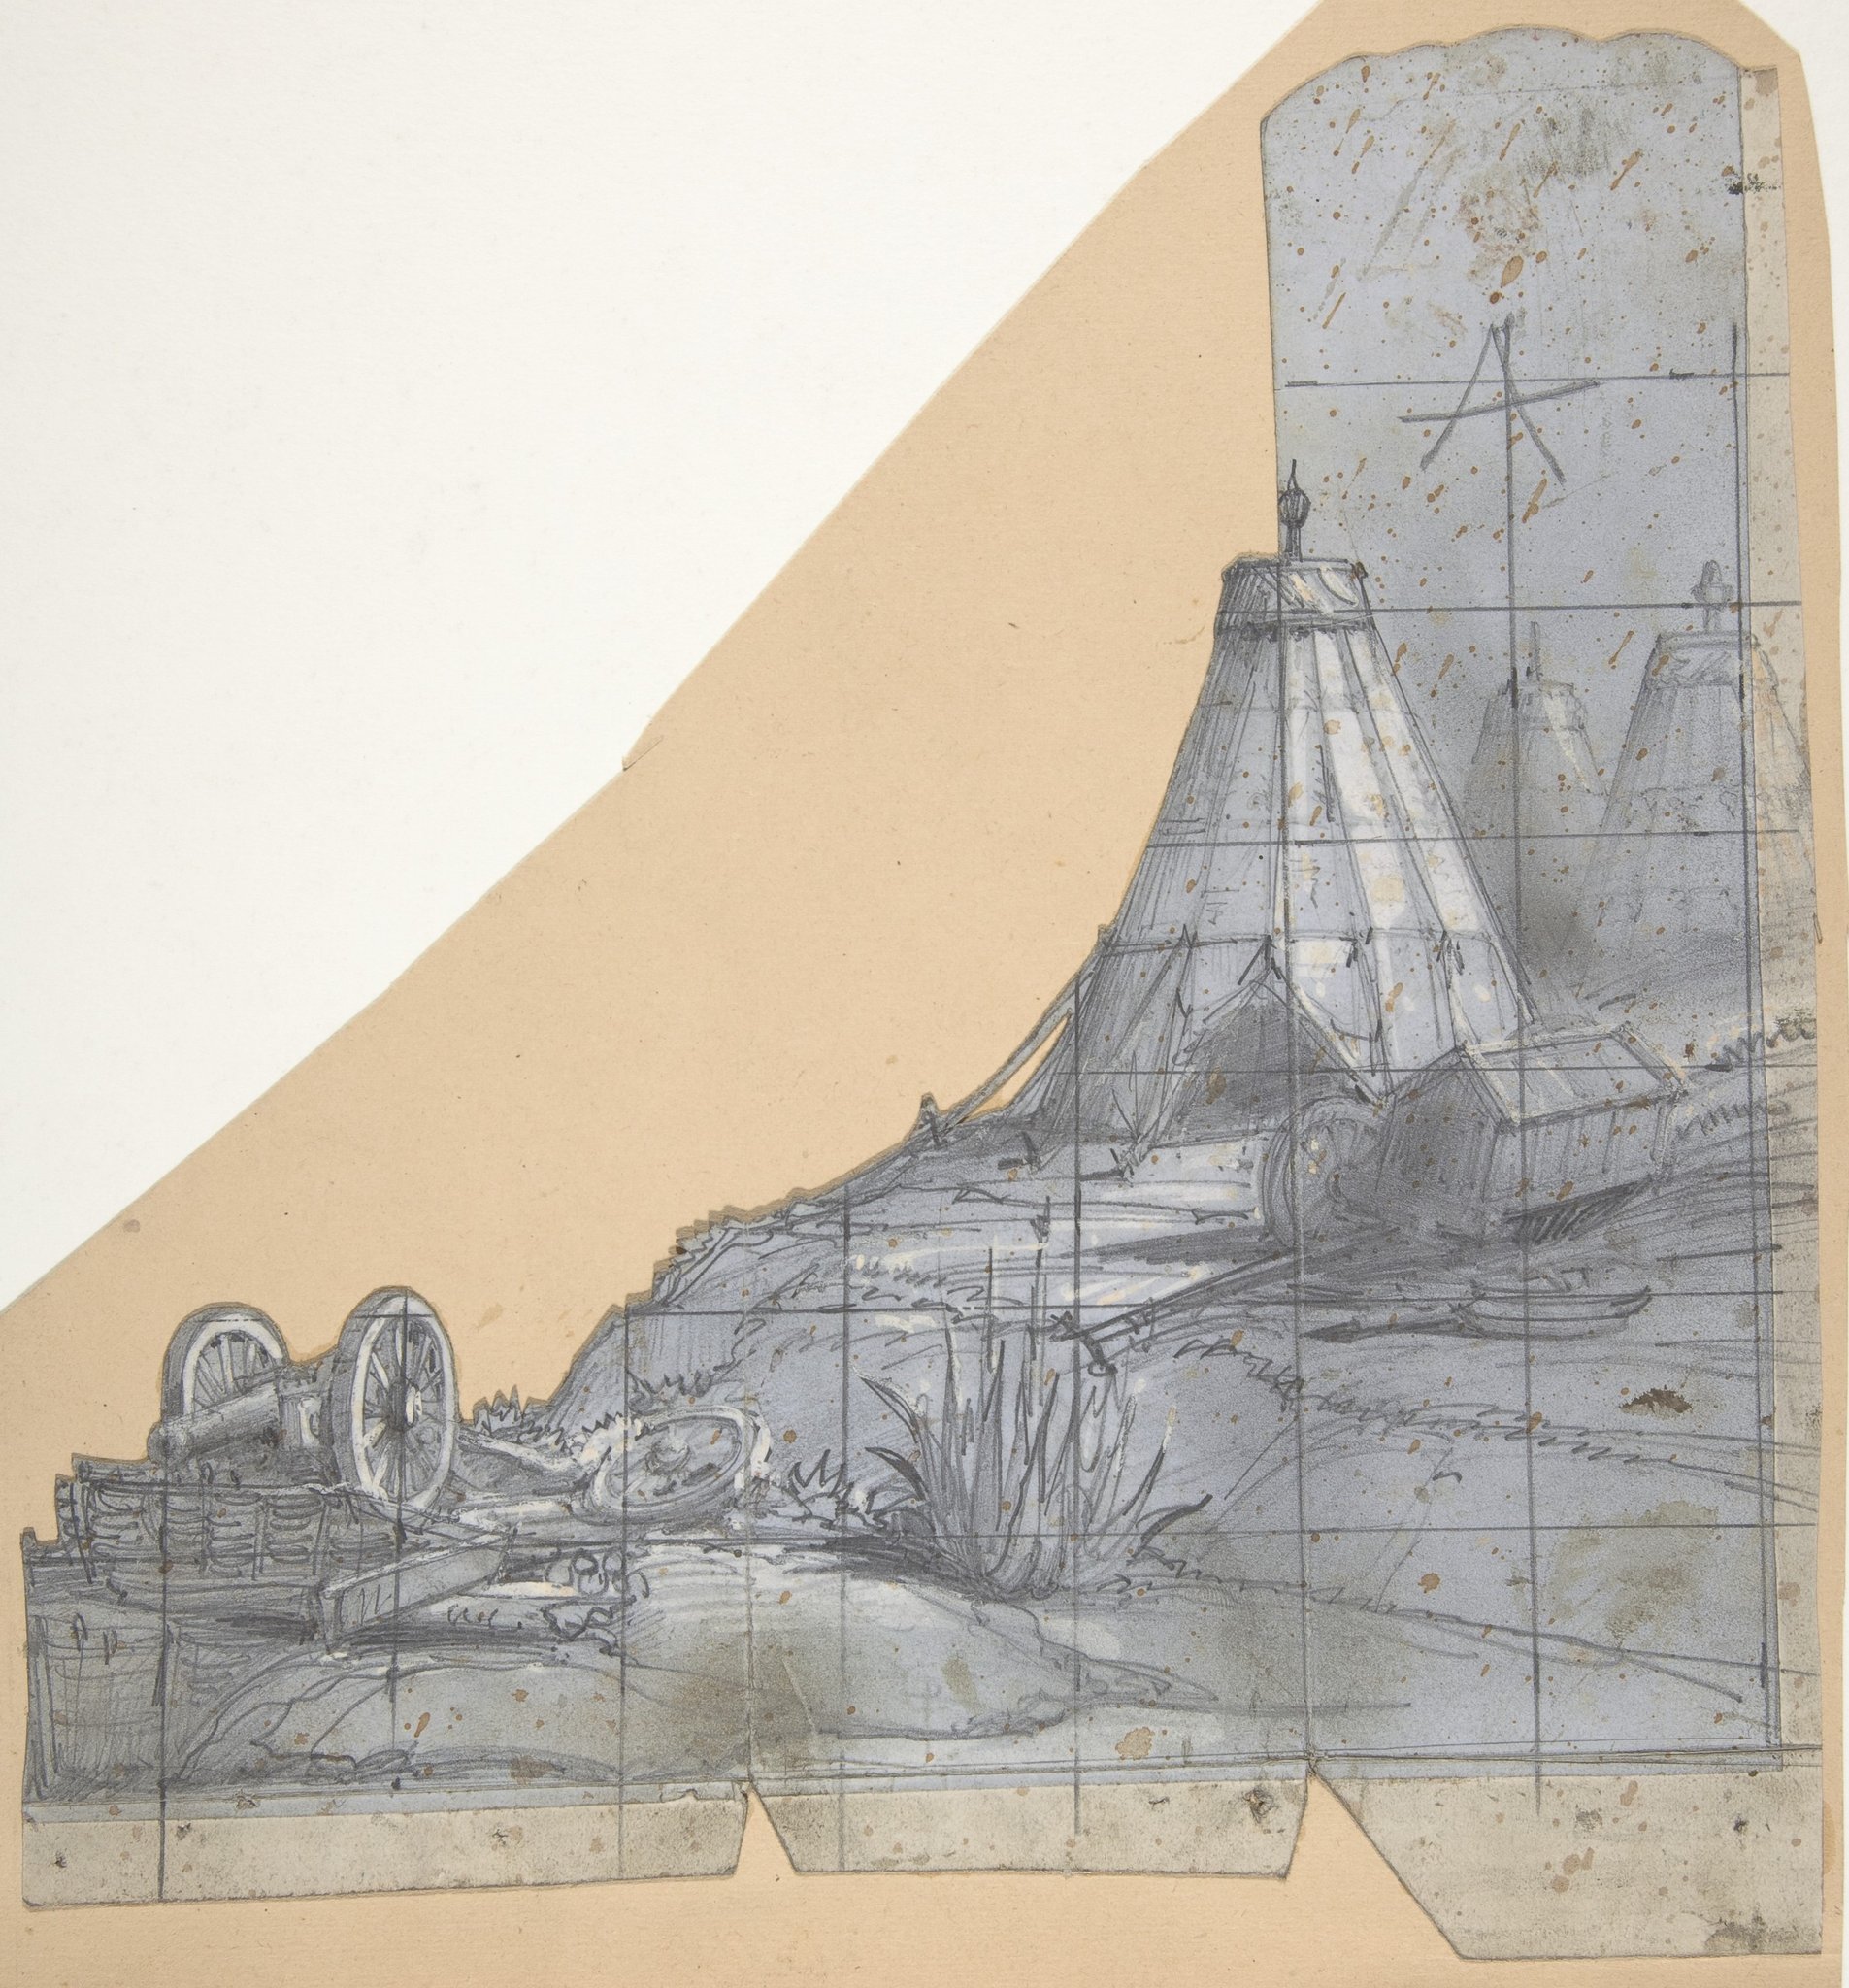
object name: drawing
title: Design for a Stage Set at the Opéra, Paris: Tent and Overturned Wagon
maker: eugène cicéri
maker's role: artist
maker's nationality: french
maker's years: 1813-1890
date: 1830-1890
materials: graphite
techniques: heightening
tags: tents,cannons,stage design